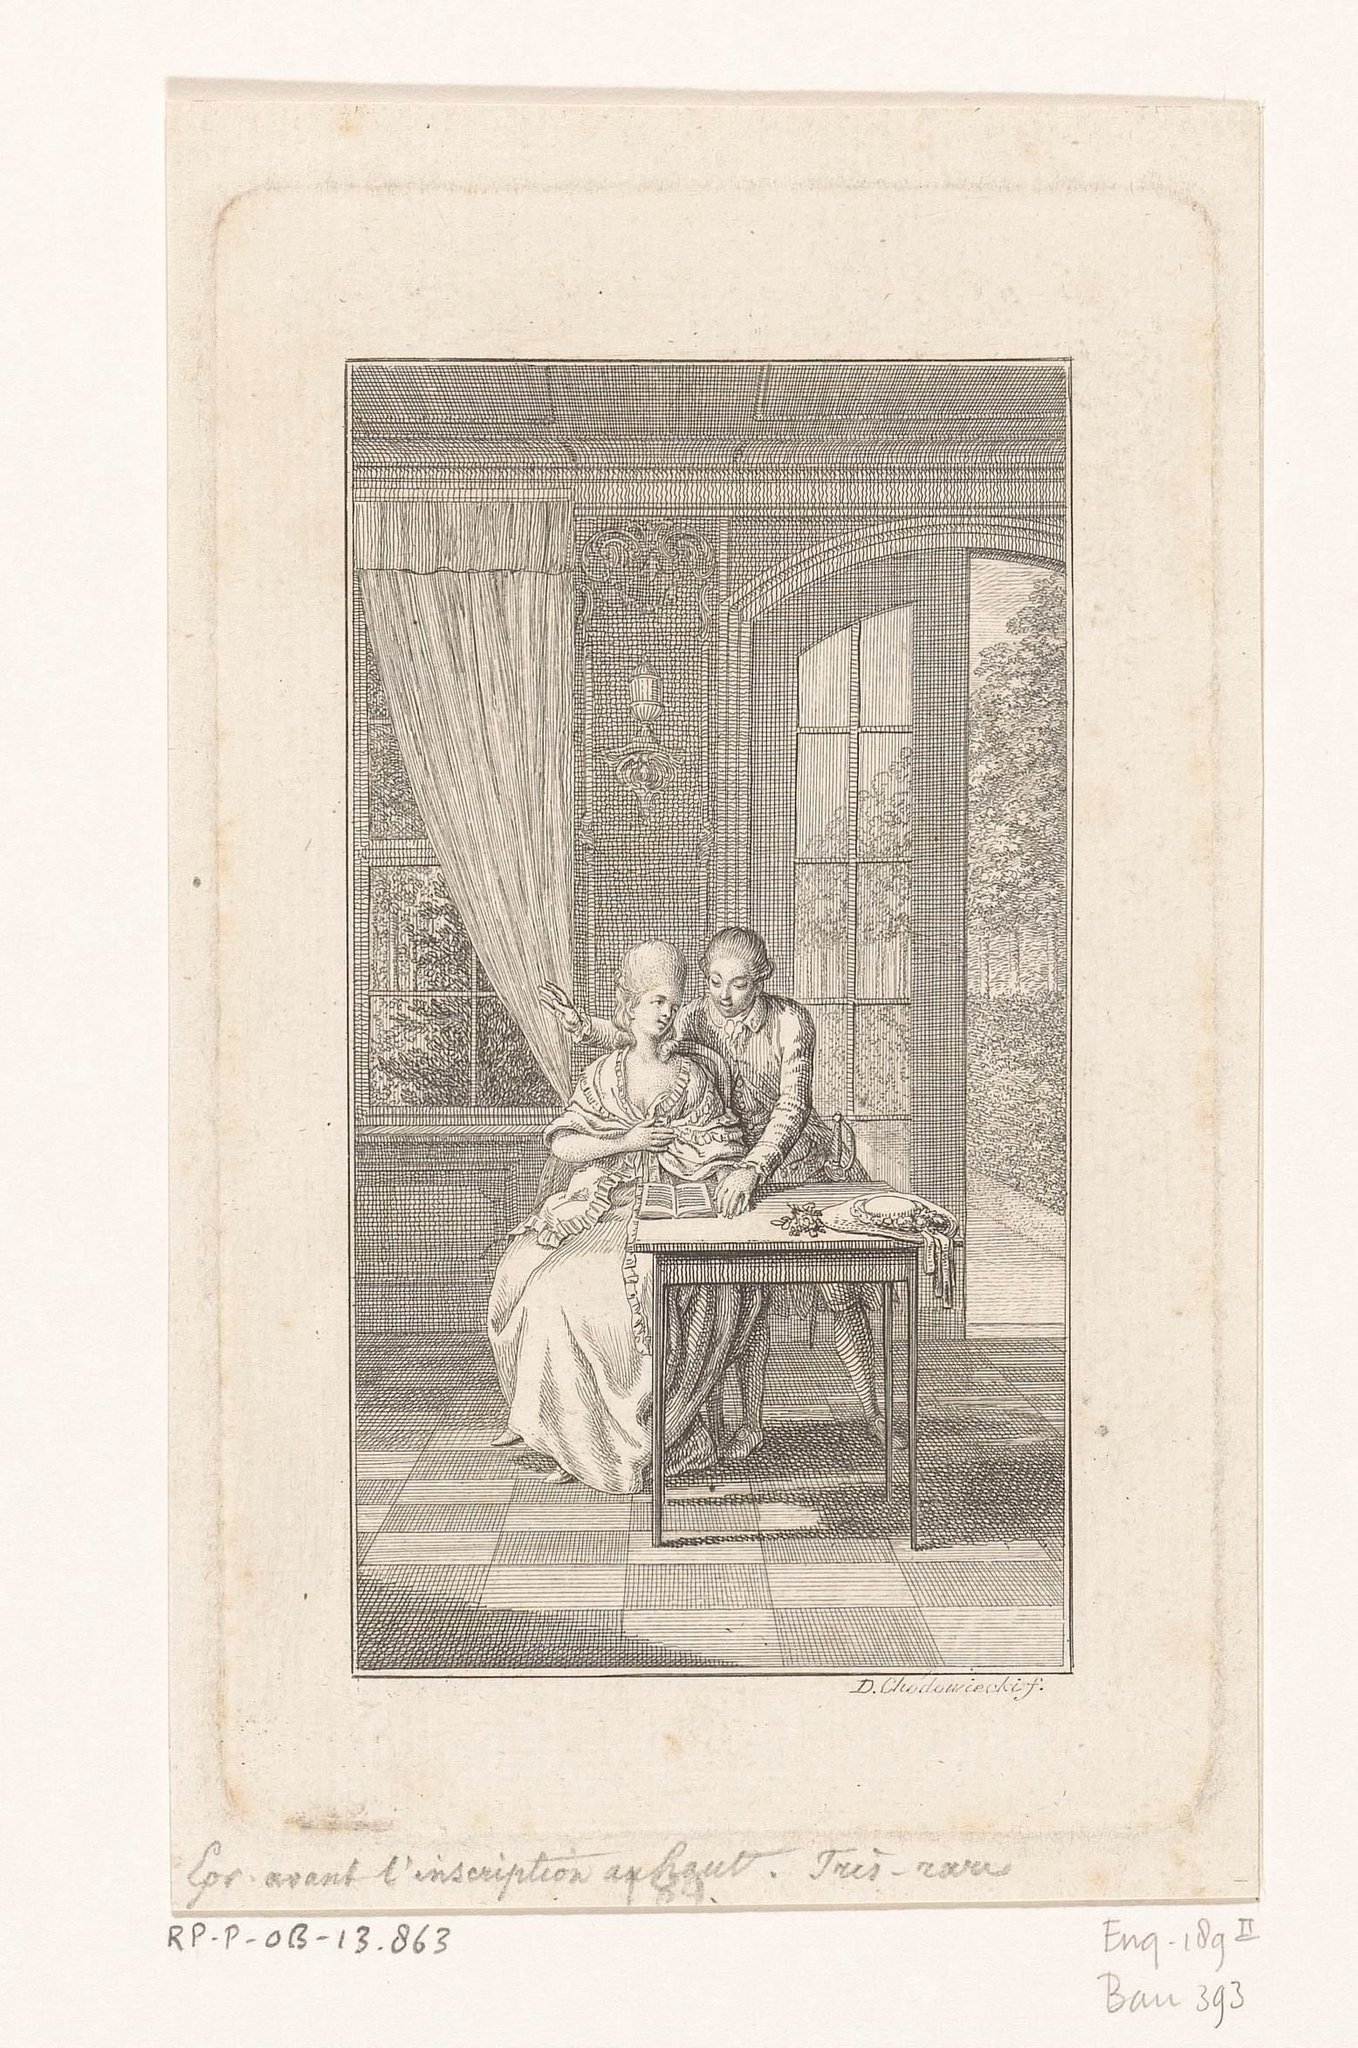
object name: print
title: Carl Ferdiner verrast Julie in het tuinhuis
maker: daniel nikolaus chodowiecki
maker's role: draughtsman, print maker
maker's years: 1726-1801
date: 1777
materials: paper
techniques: etching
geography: berlin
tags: reading, literature, book - mm - book open, summer-house, arbour, garden-house (dutch: 'theekoepel')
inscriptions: collector's mark: Lugt 2228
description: Carl Ferdiner verrast Julie die in het tuinhuis zit te lezen in 'Messias' van Friedrich Gottlieb Klopstock. Wanneer Julie Carl opmerkt trekt ze haar omslagdoek over haar borst.